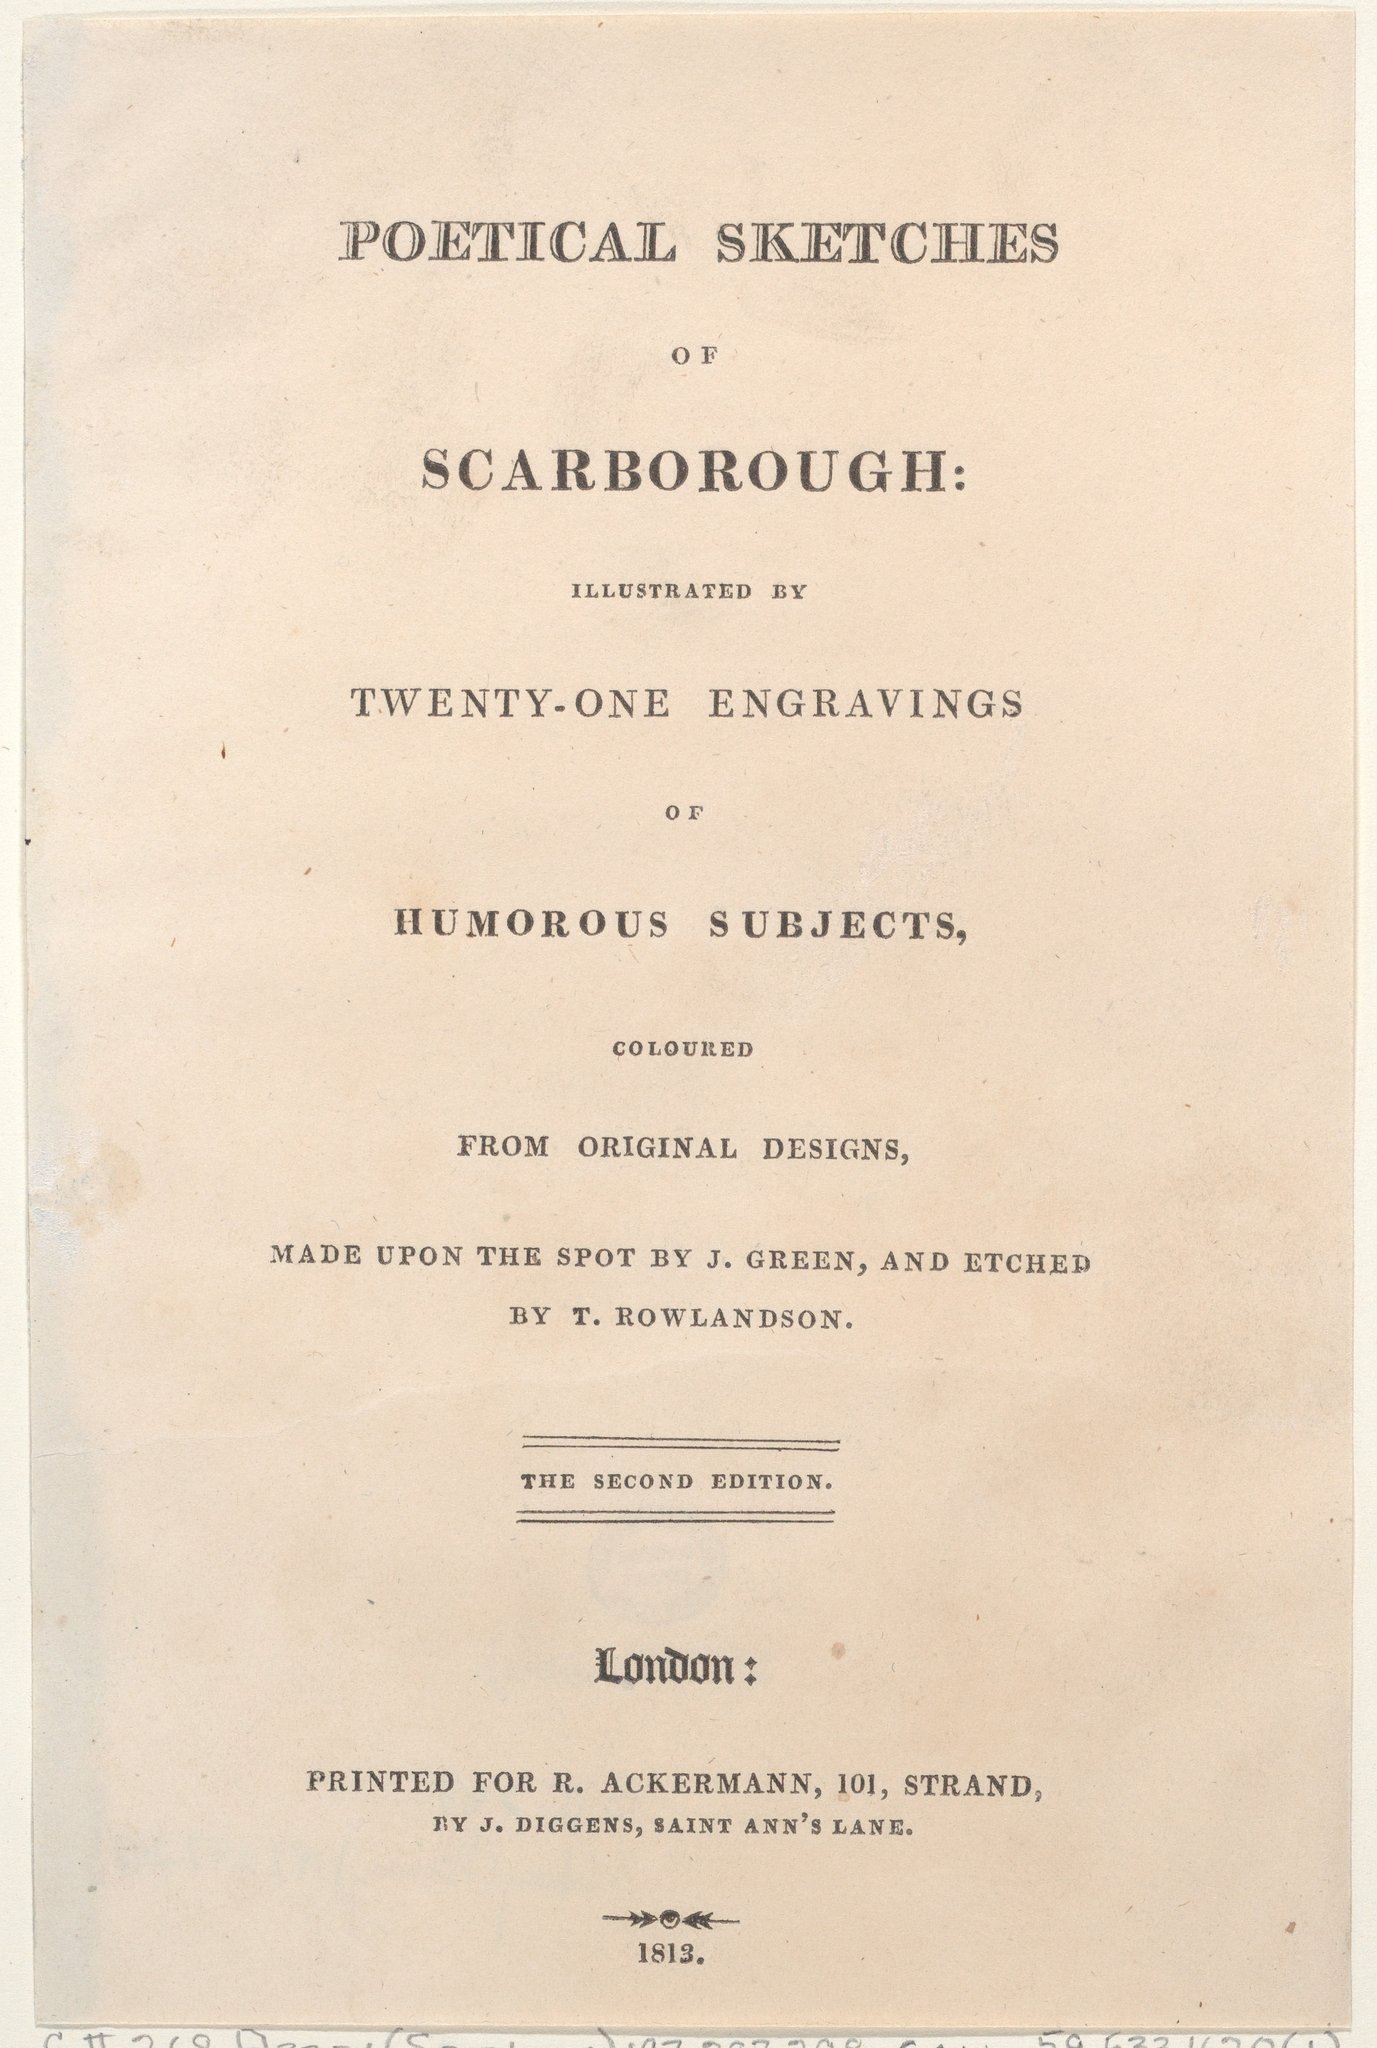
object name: print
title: Title Page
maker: thomas rowlandson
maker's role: artist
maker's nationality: british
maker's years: 1757-1827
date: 1813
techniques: letterpress